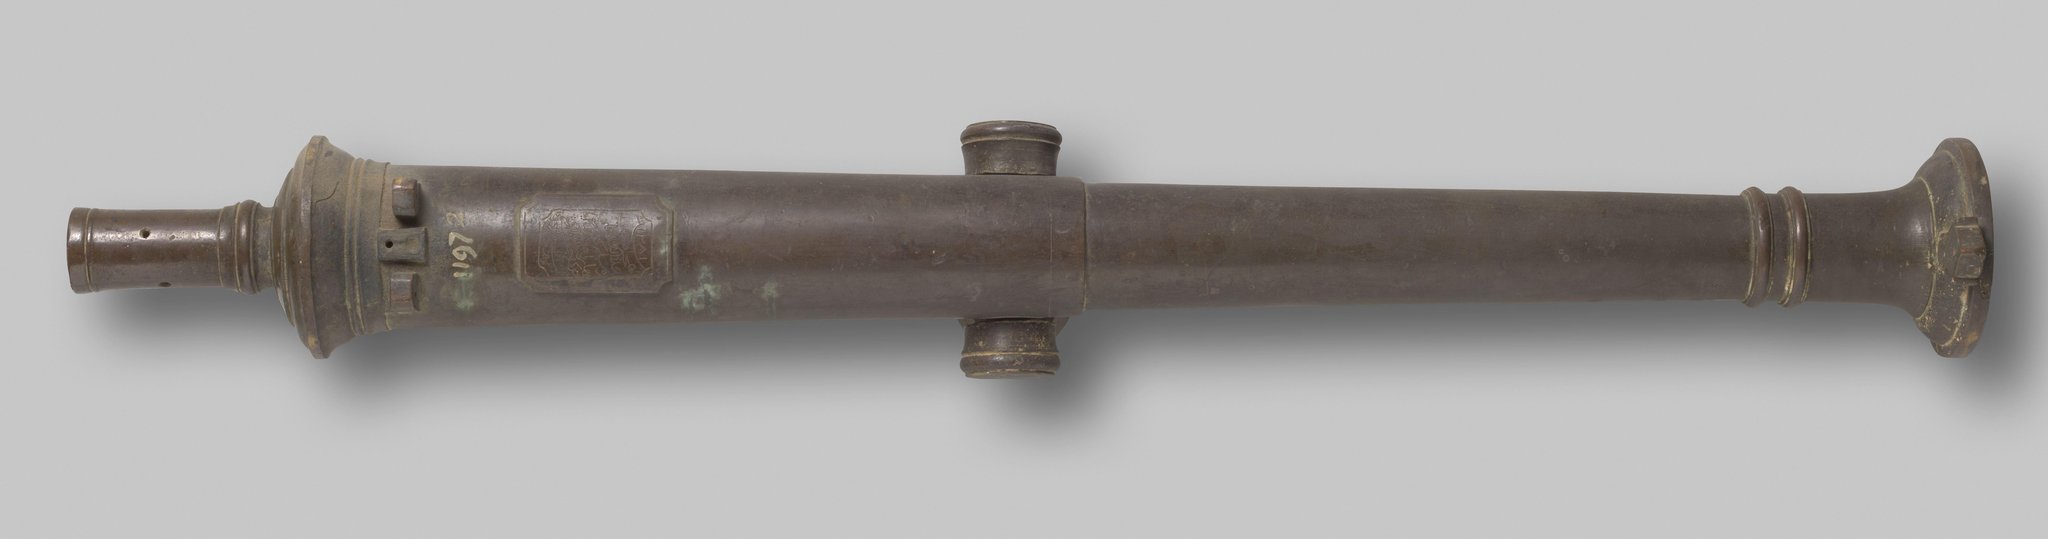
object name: lilla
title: Bronzen lilla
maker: abdulsamed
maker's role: geschutgieter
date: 1864-1865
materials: bronze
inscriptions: inscription: ‘سنة 1281 هجرة نبي صلا الله عليه وسلم’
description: Bronzen kanon met op de kulas een inscriptie aangebracht op een cartouche op de kulas. In de tekst wordt het jaar van vervaardiging genoemd (1281, wat staat voor 1864/1865) en de naam van de gieter Abdulsamed.